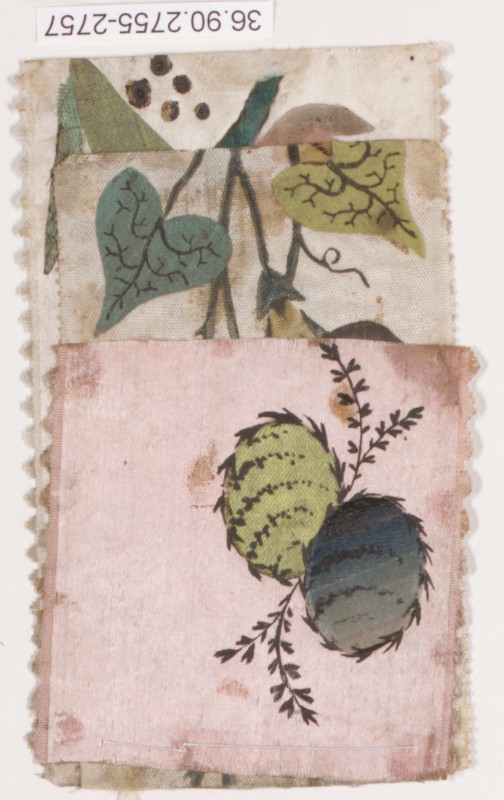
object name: ribbon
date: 1801-1900